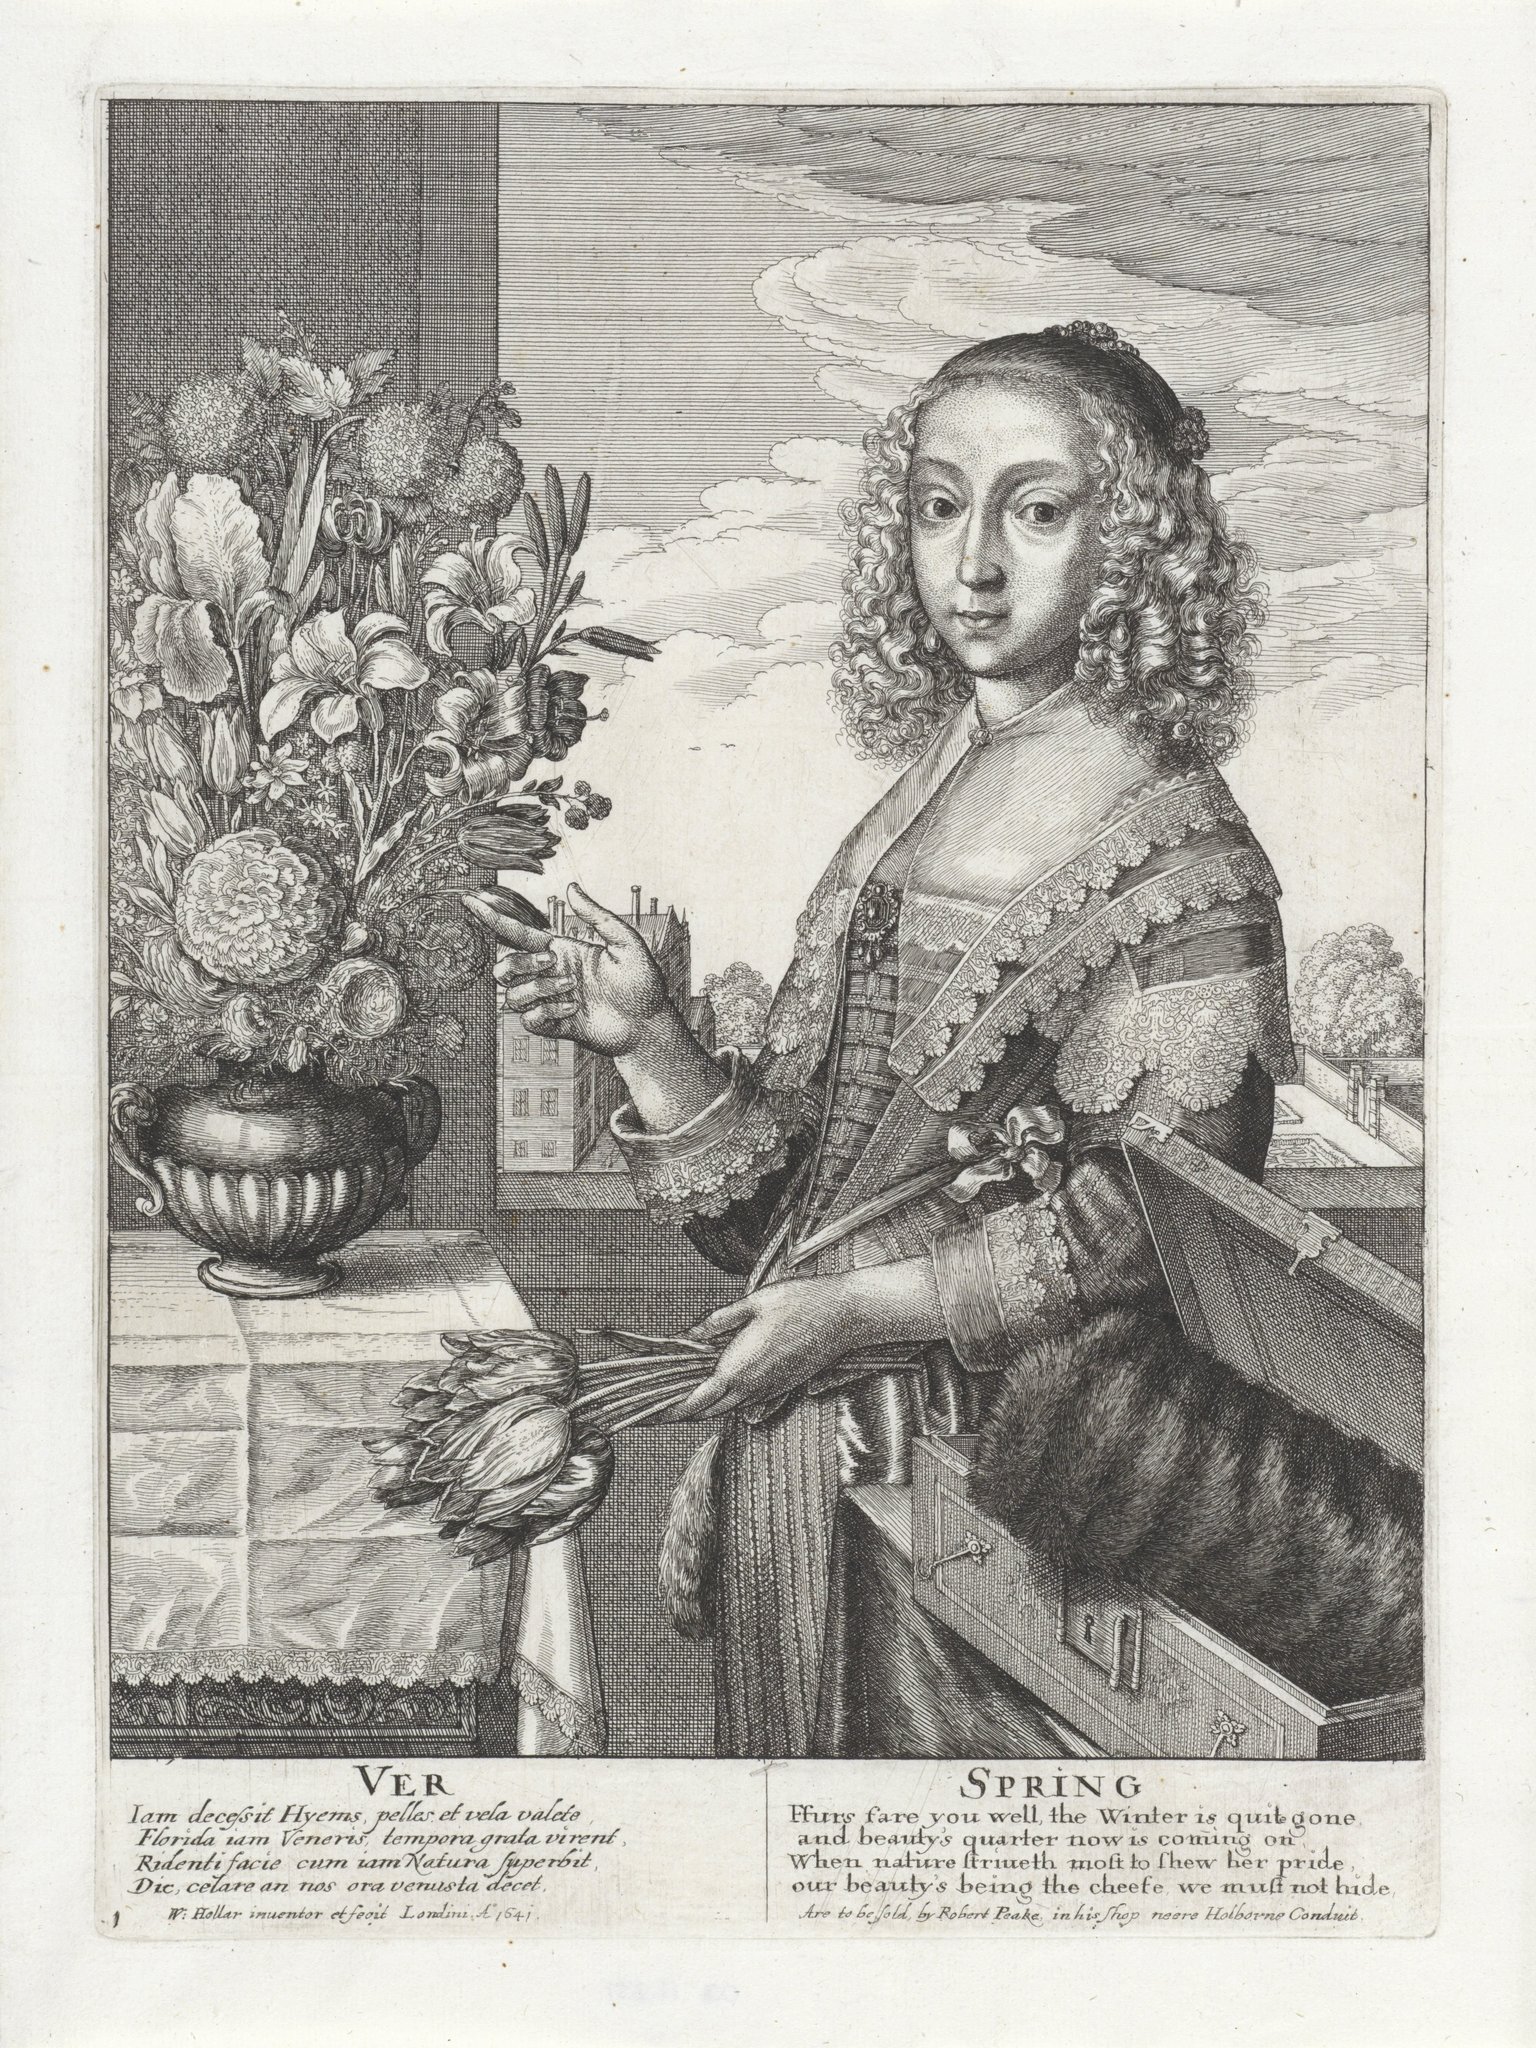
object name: print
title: Spring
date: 1641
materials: paper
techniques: etching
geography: england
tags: cut flowers; nosegay, bunch of flowers, spring, 'ver'; 'primavera' (ripa), clothes, costume (+ women's clothes), sleeves: cuffs (+ women's clothes), dress, gown (+ women's clothes), flowers: tulip, sleeves (+ women's clothes), clothing for the upper part of the body (with name) (+ women's clothes)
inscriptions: collector's mark: Lugt 240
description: Spring is frequently presented as a comely young maiden holding blossoms, or posing near a vase of flowers. In Hollar’s print the large, almost overblown, costly tulips predominate. The tulips in 17th-century floral still lifes are often already in full bloom. Evidently, enthusiasts at that time were intrigued by the blossoms’ fanciful forms.